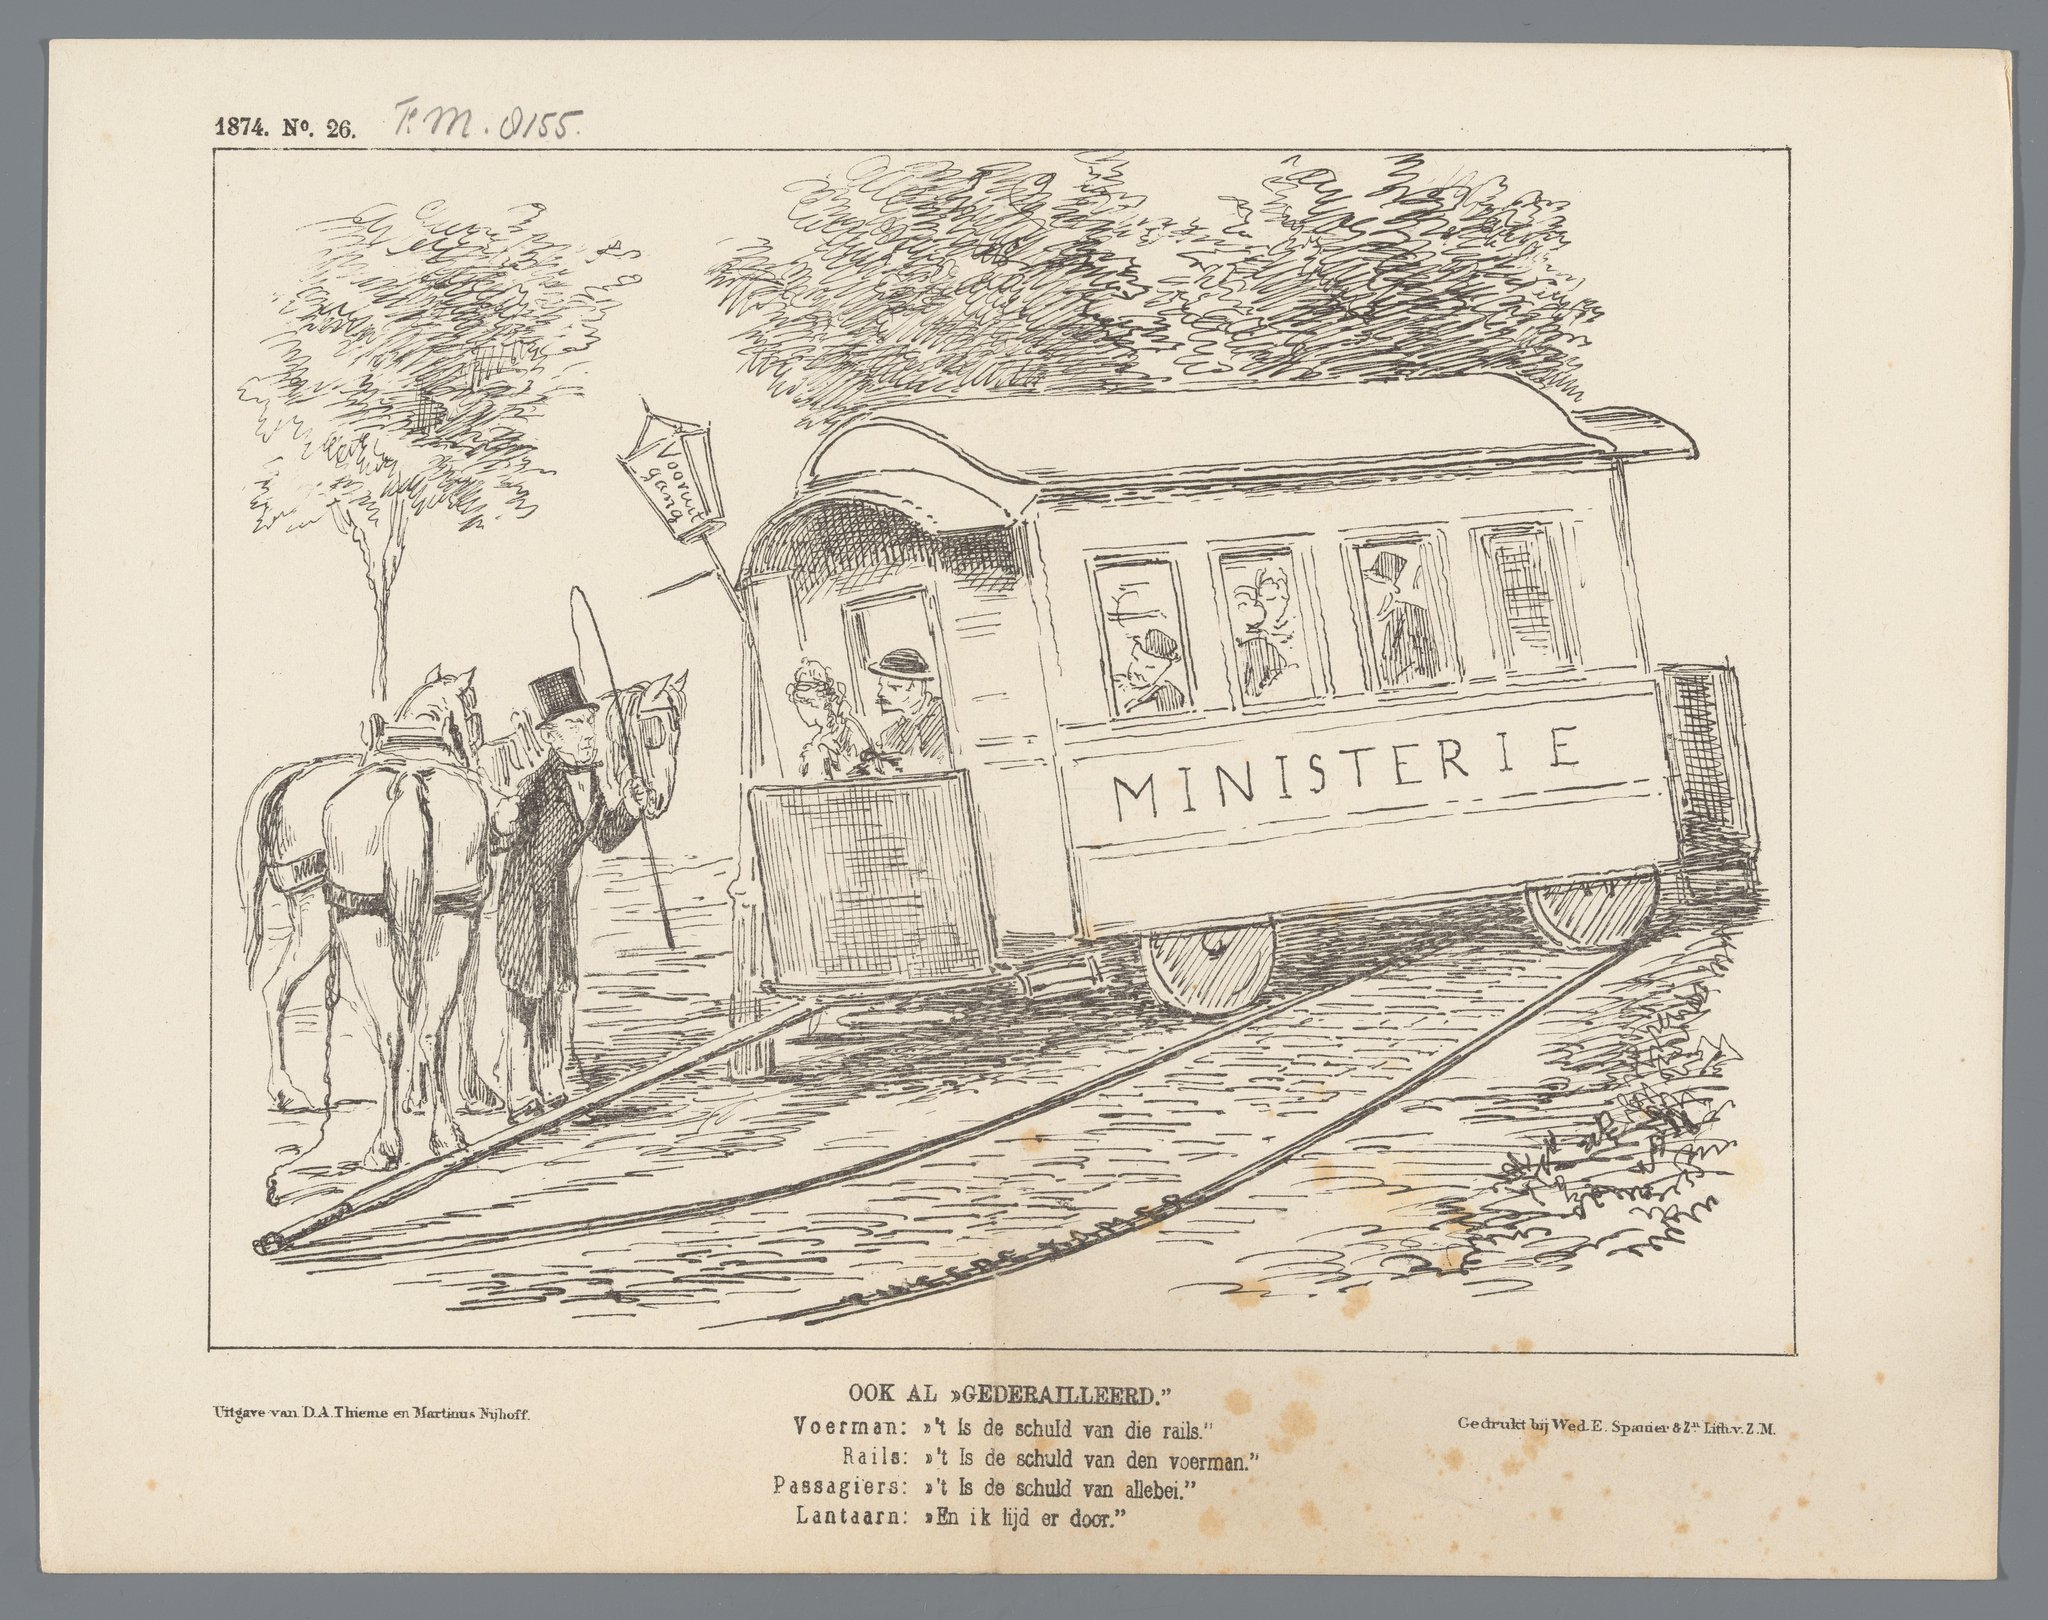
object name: print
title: Ook al "gederailleerd"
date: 1874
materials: paper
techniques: lithograph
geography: netherlands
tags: tram, the hague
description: Spotprent op de ministeriële krisis, 1874. De Haagse tramwagen is ontspoord. Plaat verschenen bij het weekblad De Nederlandsche Spectator, nr. 26, 1874.